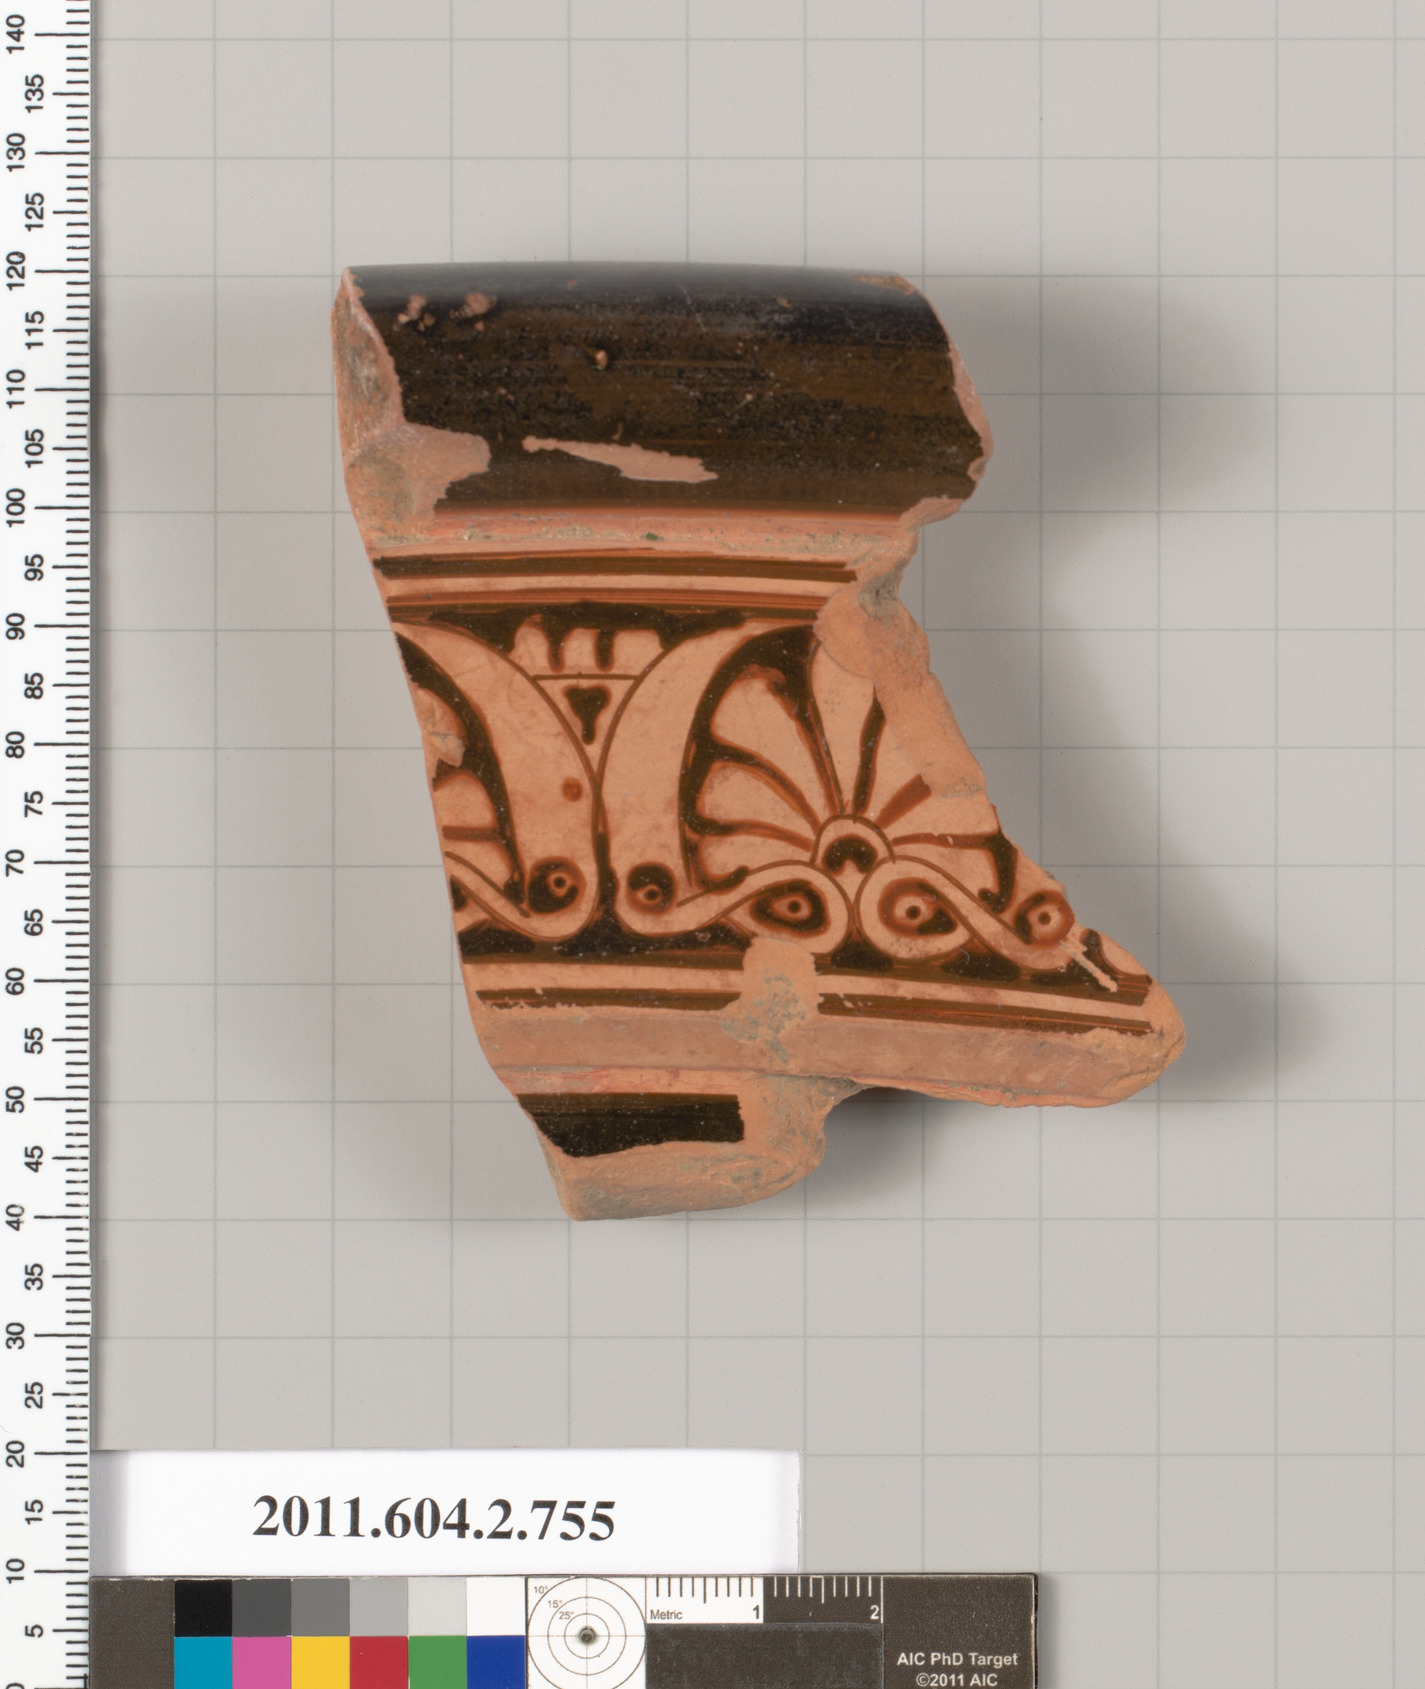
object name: calyx krater fragment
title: Terracotta fragment of a calyx-krater (bowl for mixing wine and water)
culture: greek, attic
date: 490-470 BCE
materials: terracotta